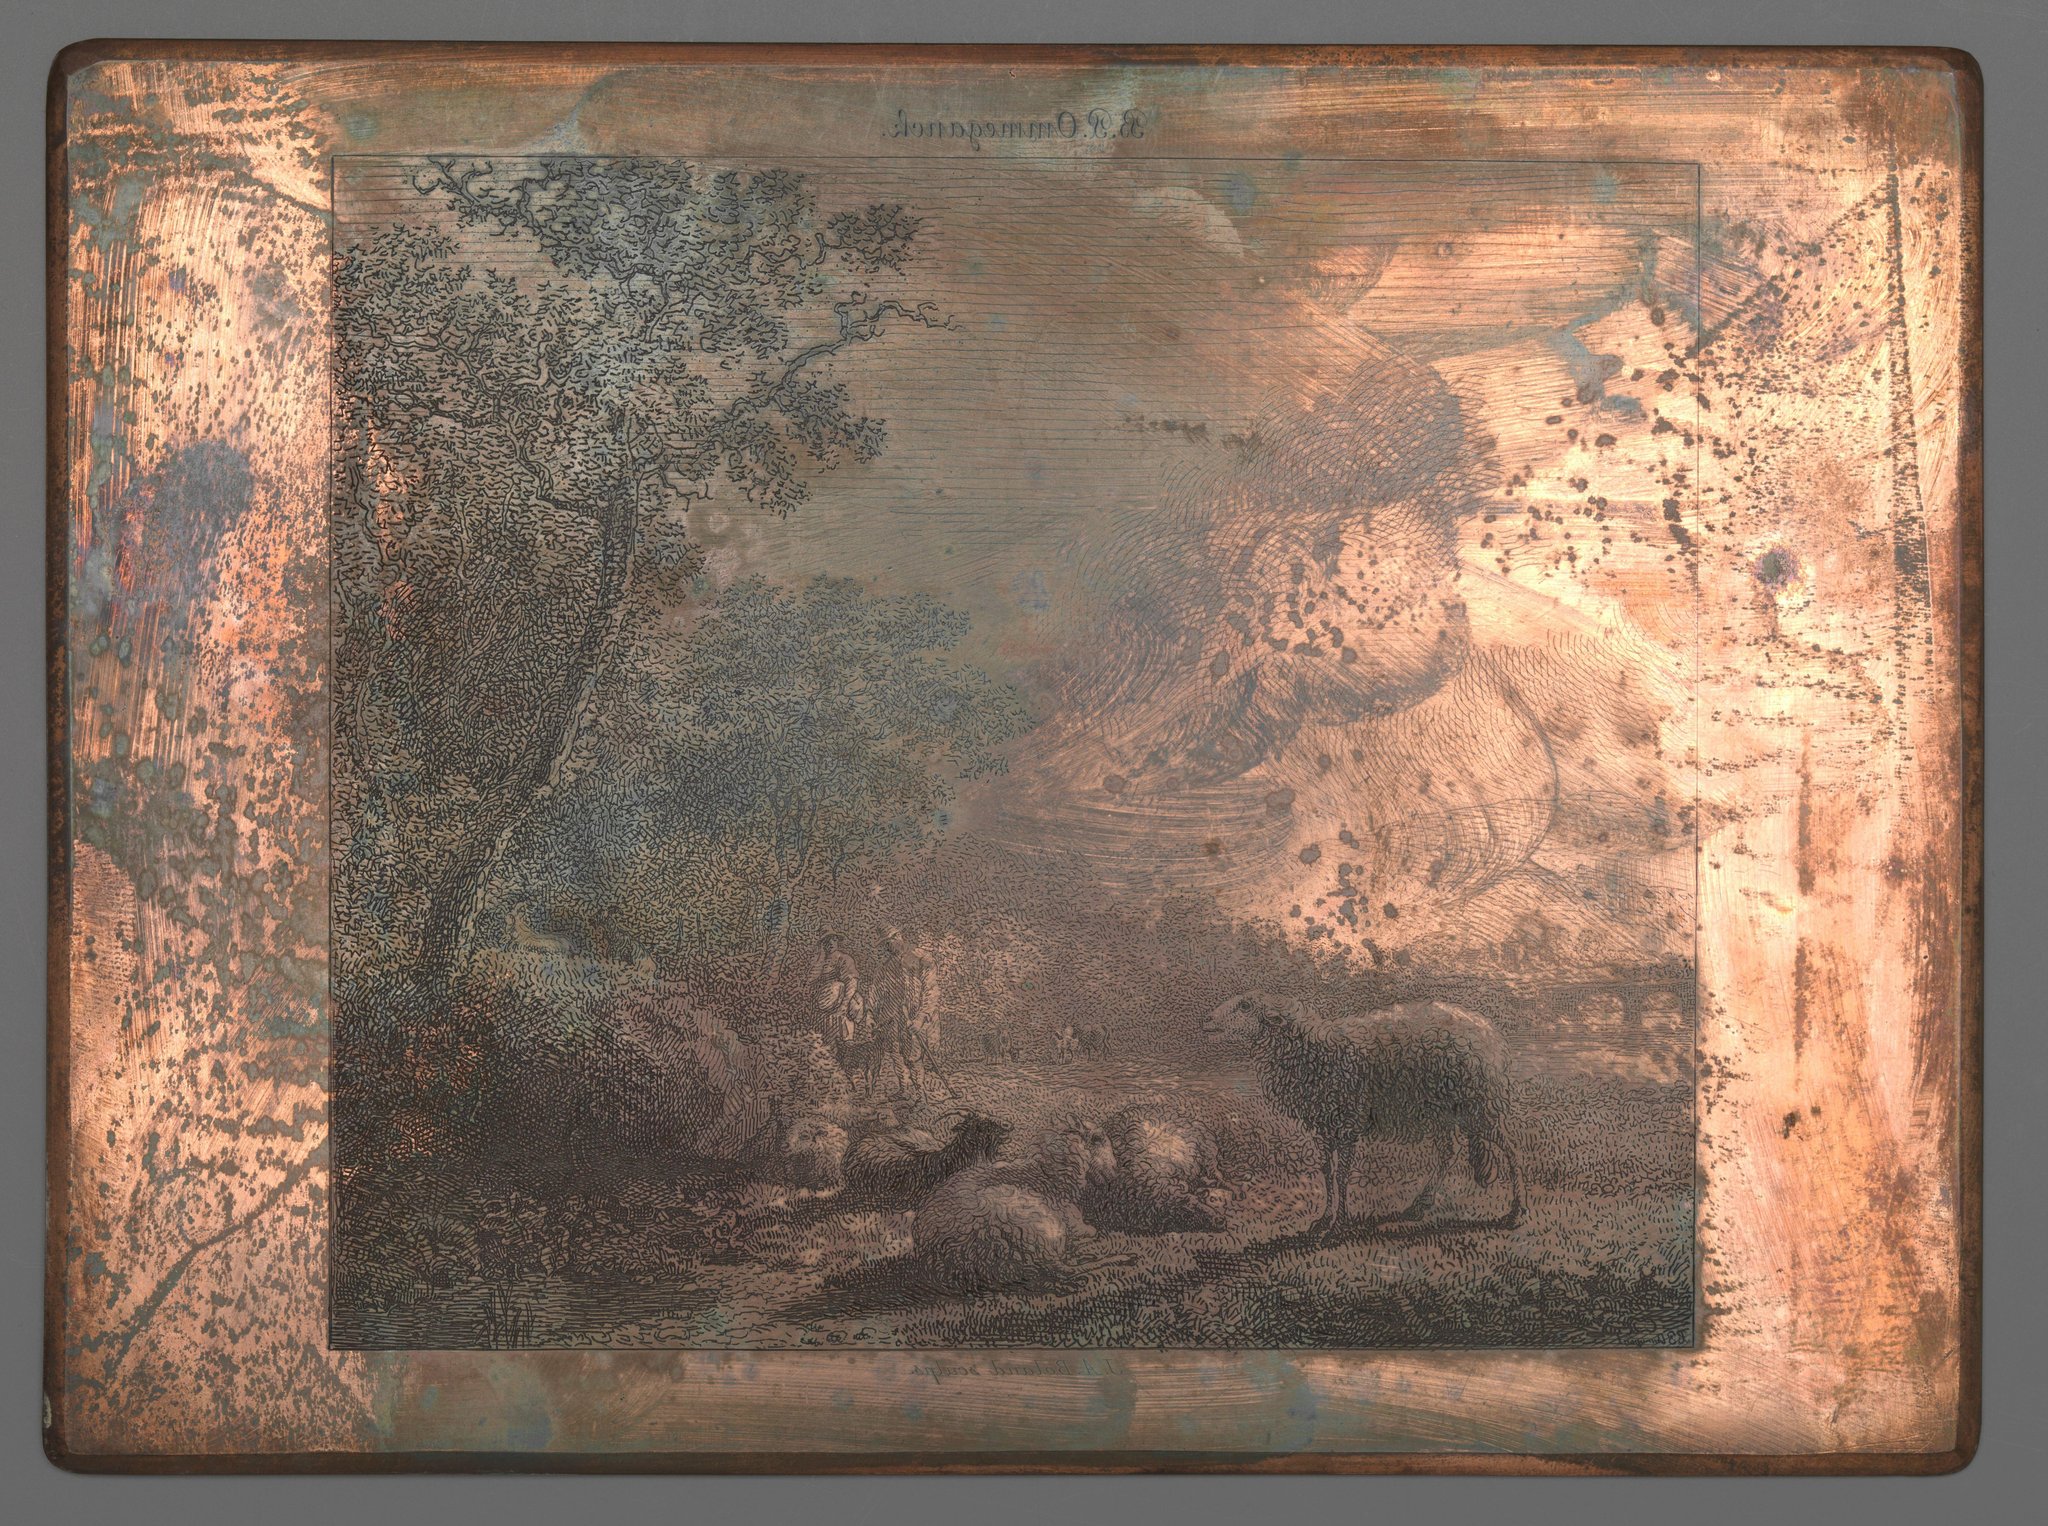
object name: copper plate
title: Schapen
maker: johannes arnoldus boland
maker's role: print maker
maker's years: 1838-1922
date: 1848-1909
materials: copper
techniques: etching